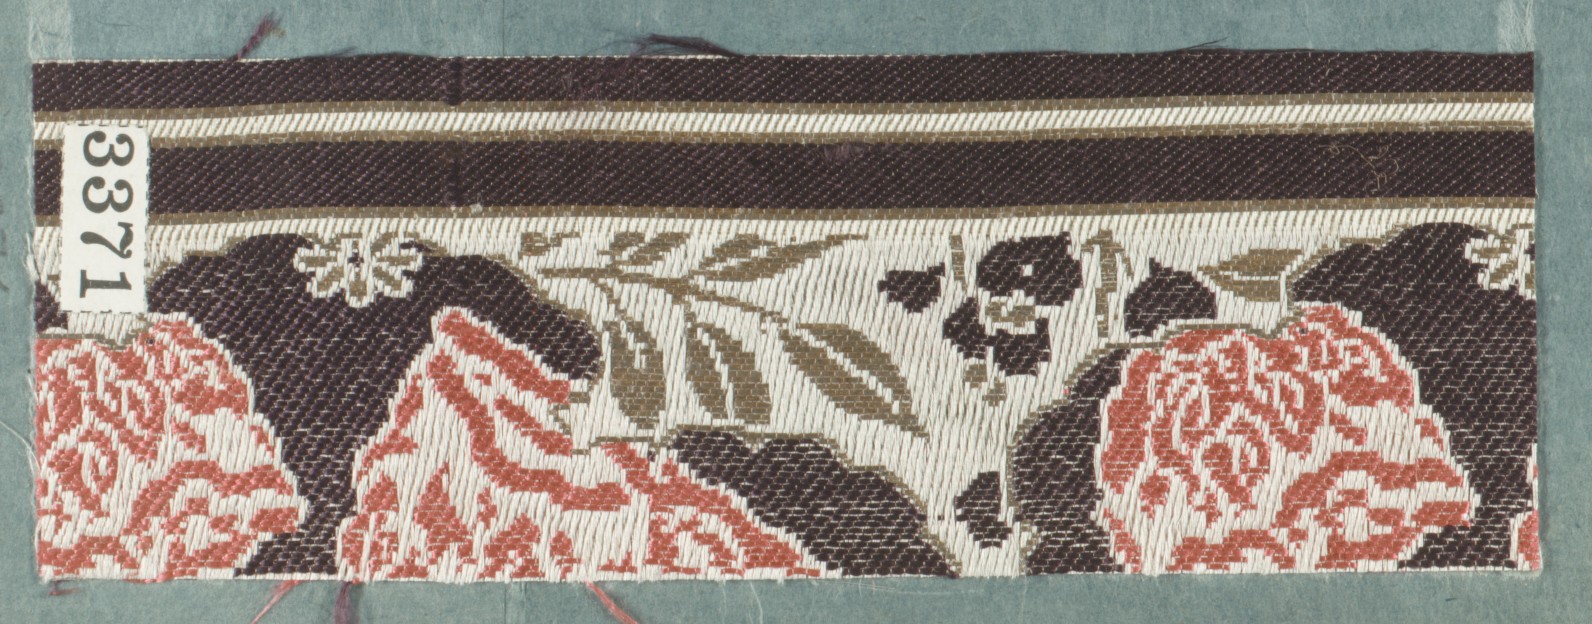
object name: textile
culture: japanese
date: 1801-1900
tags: flowers